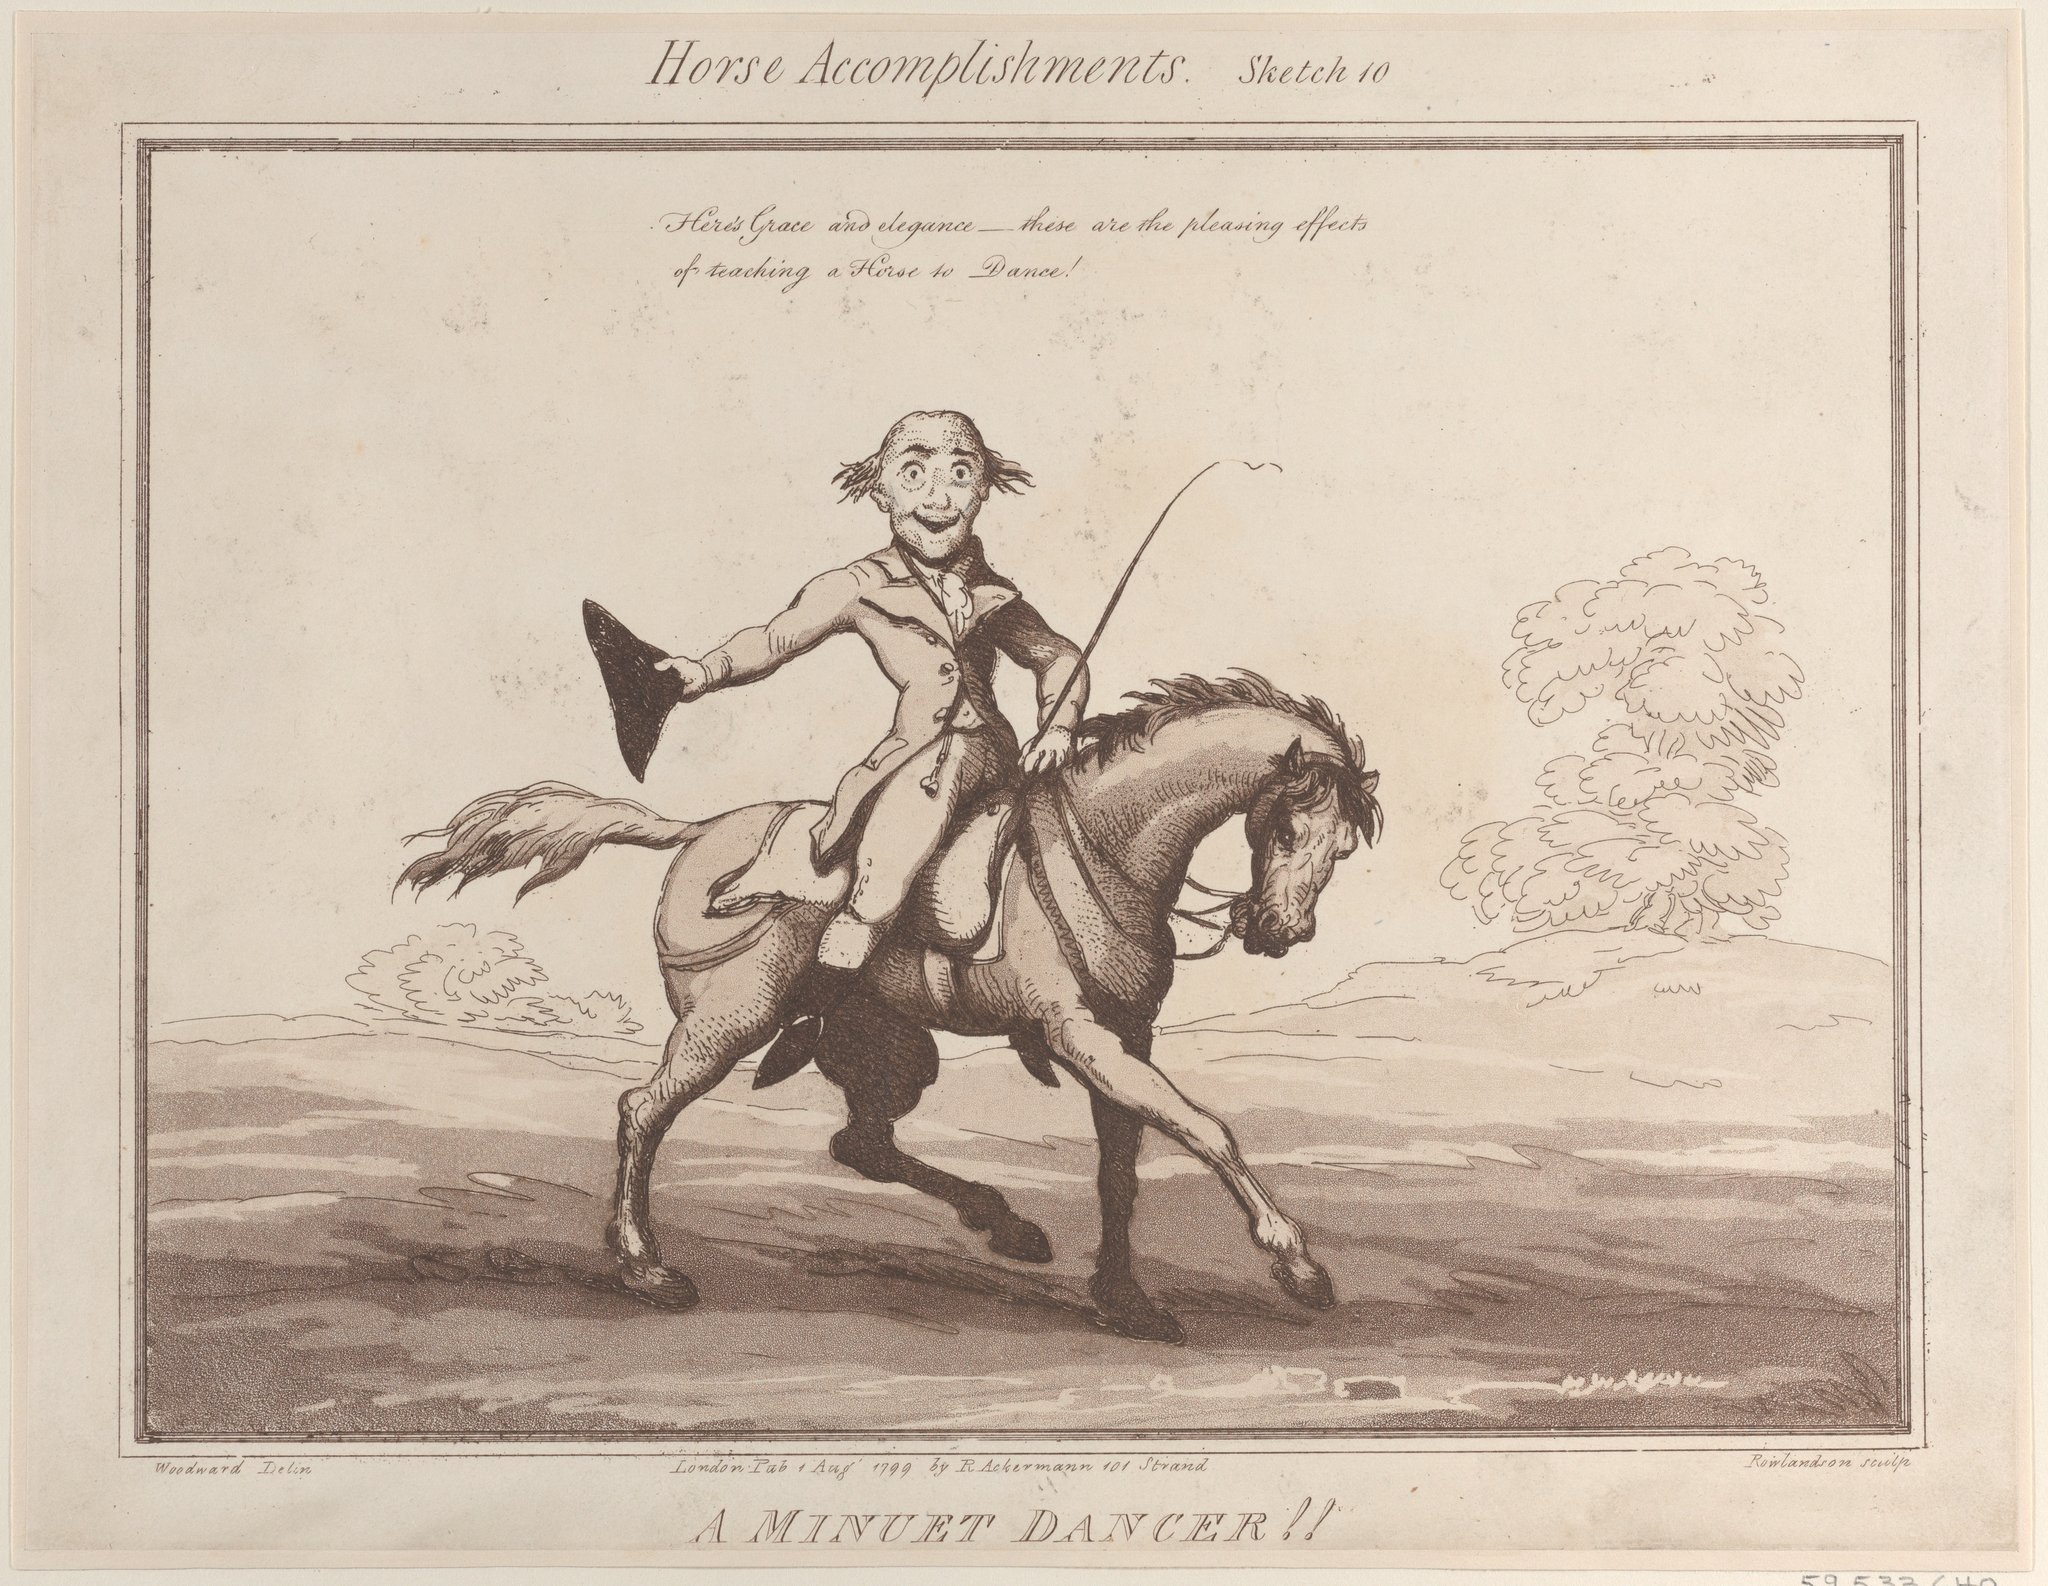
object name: print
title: Horse Accomplishments, Sketch 10: A Minuet Dancer !!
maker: thomas rowlandson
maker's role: artist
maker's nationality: british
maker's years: 1757-1827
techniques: aquatint, etching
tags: satire,men,horses,caricature